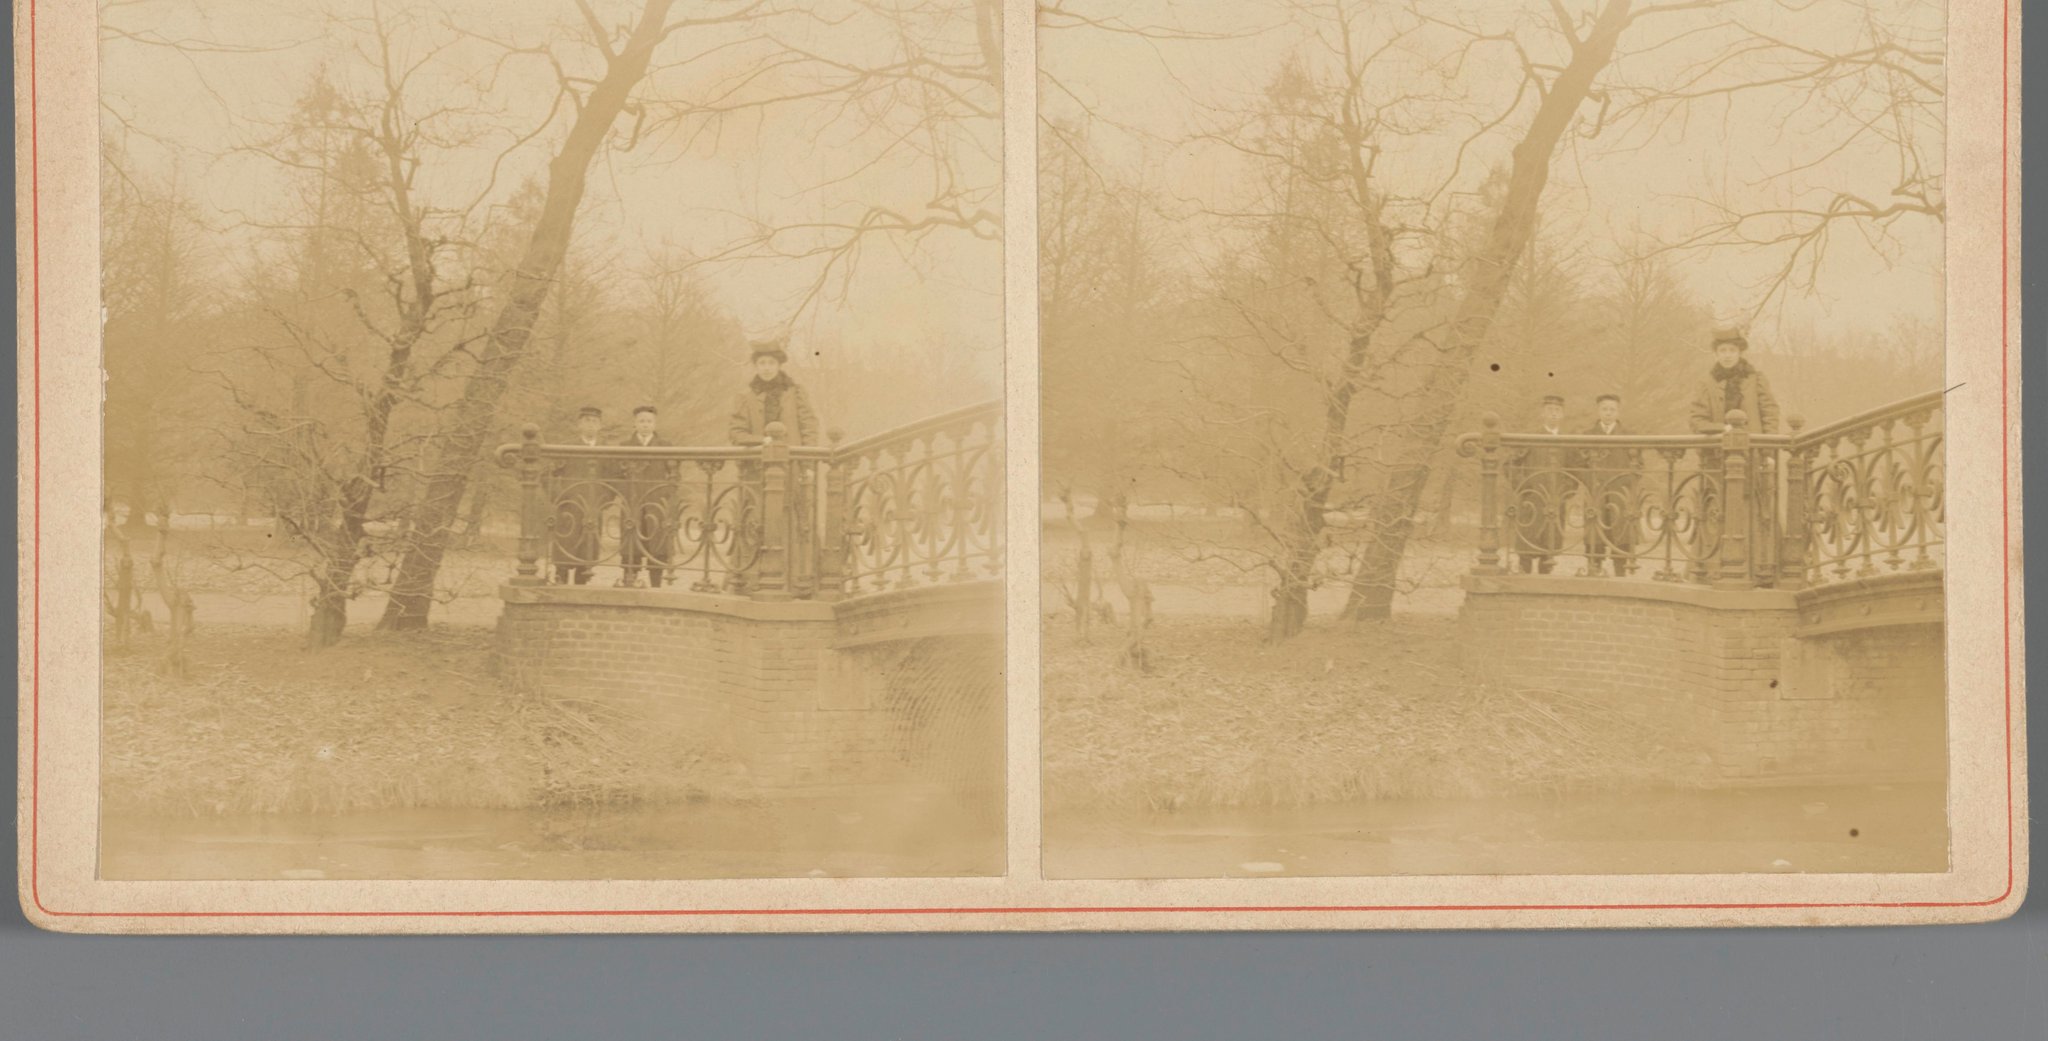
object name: stereograph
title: Vondelpark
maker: Anonymous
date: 1900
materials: cardboard, photographic support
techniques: gelatin silver print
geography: amsterdam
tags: vondelpark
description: Het Vondelpark te Amsterdam. Onderdeel van een groep van 5 foto's en 19 stereofoto's gemaakt door een onbekende amateurfotograaf rond 1900 in Amsterdam, de Ardennen en Denemarken.